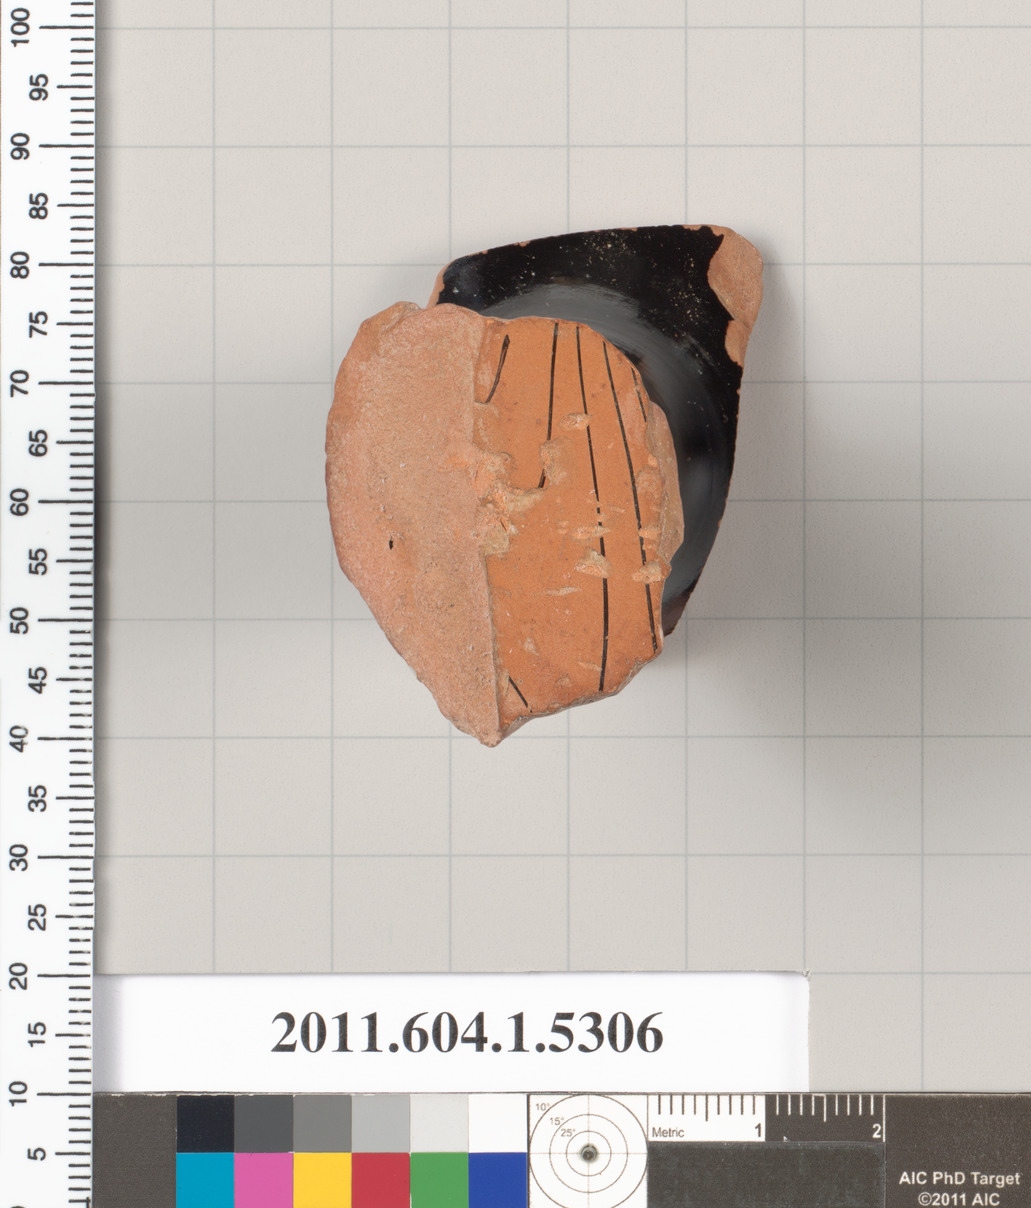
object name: kylix fragment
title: Terracotta fragment of a kylix (drinking cup)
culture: greek, attic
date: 475-451 BCE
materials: terracotta